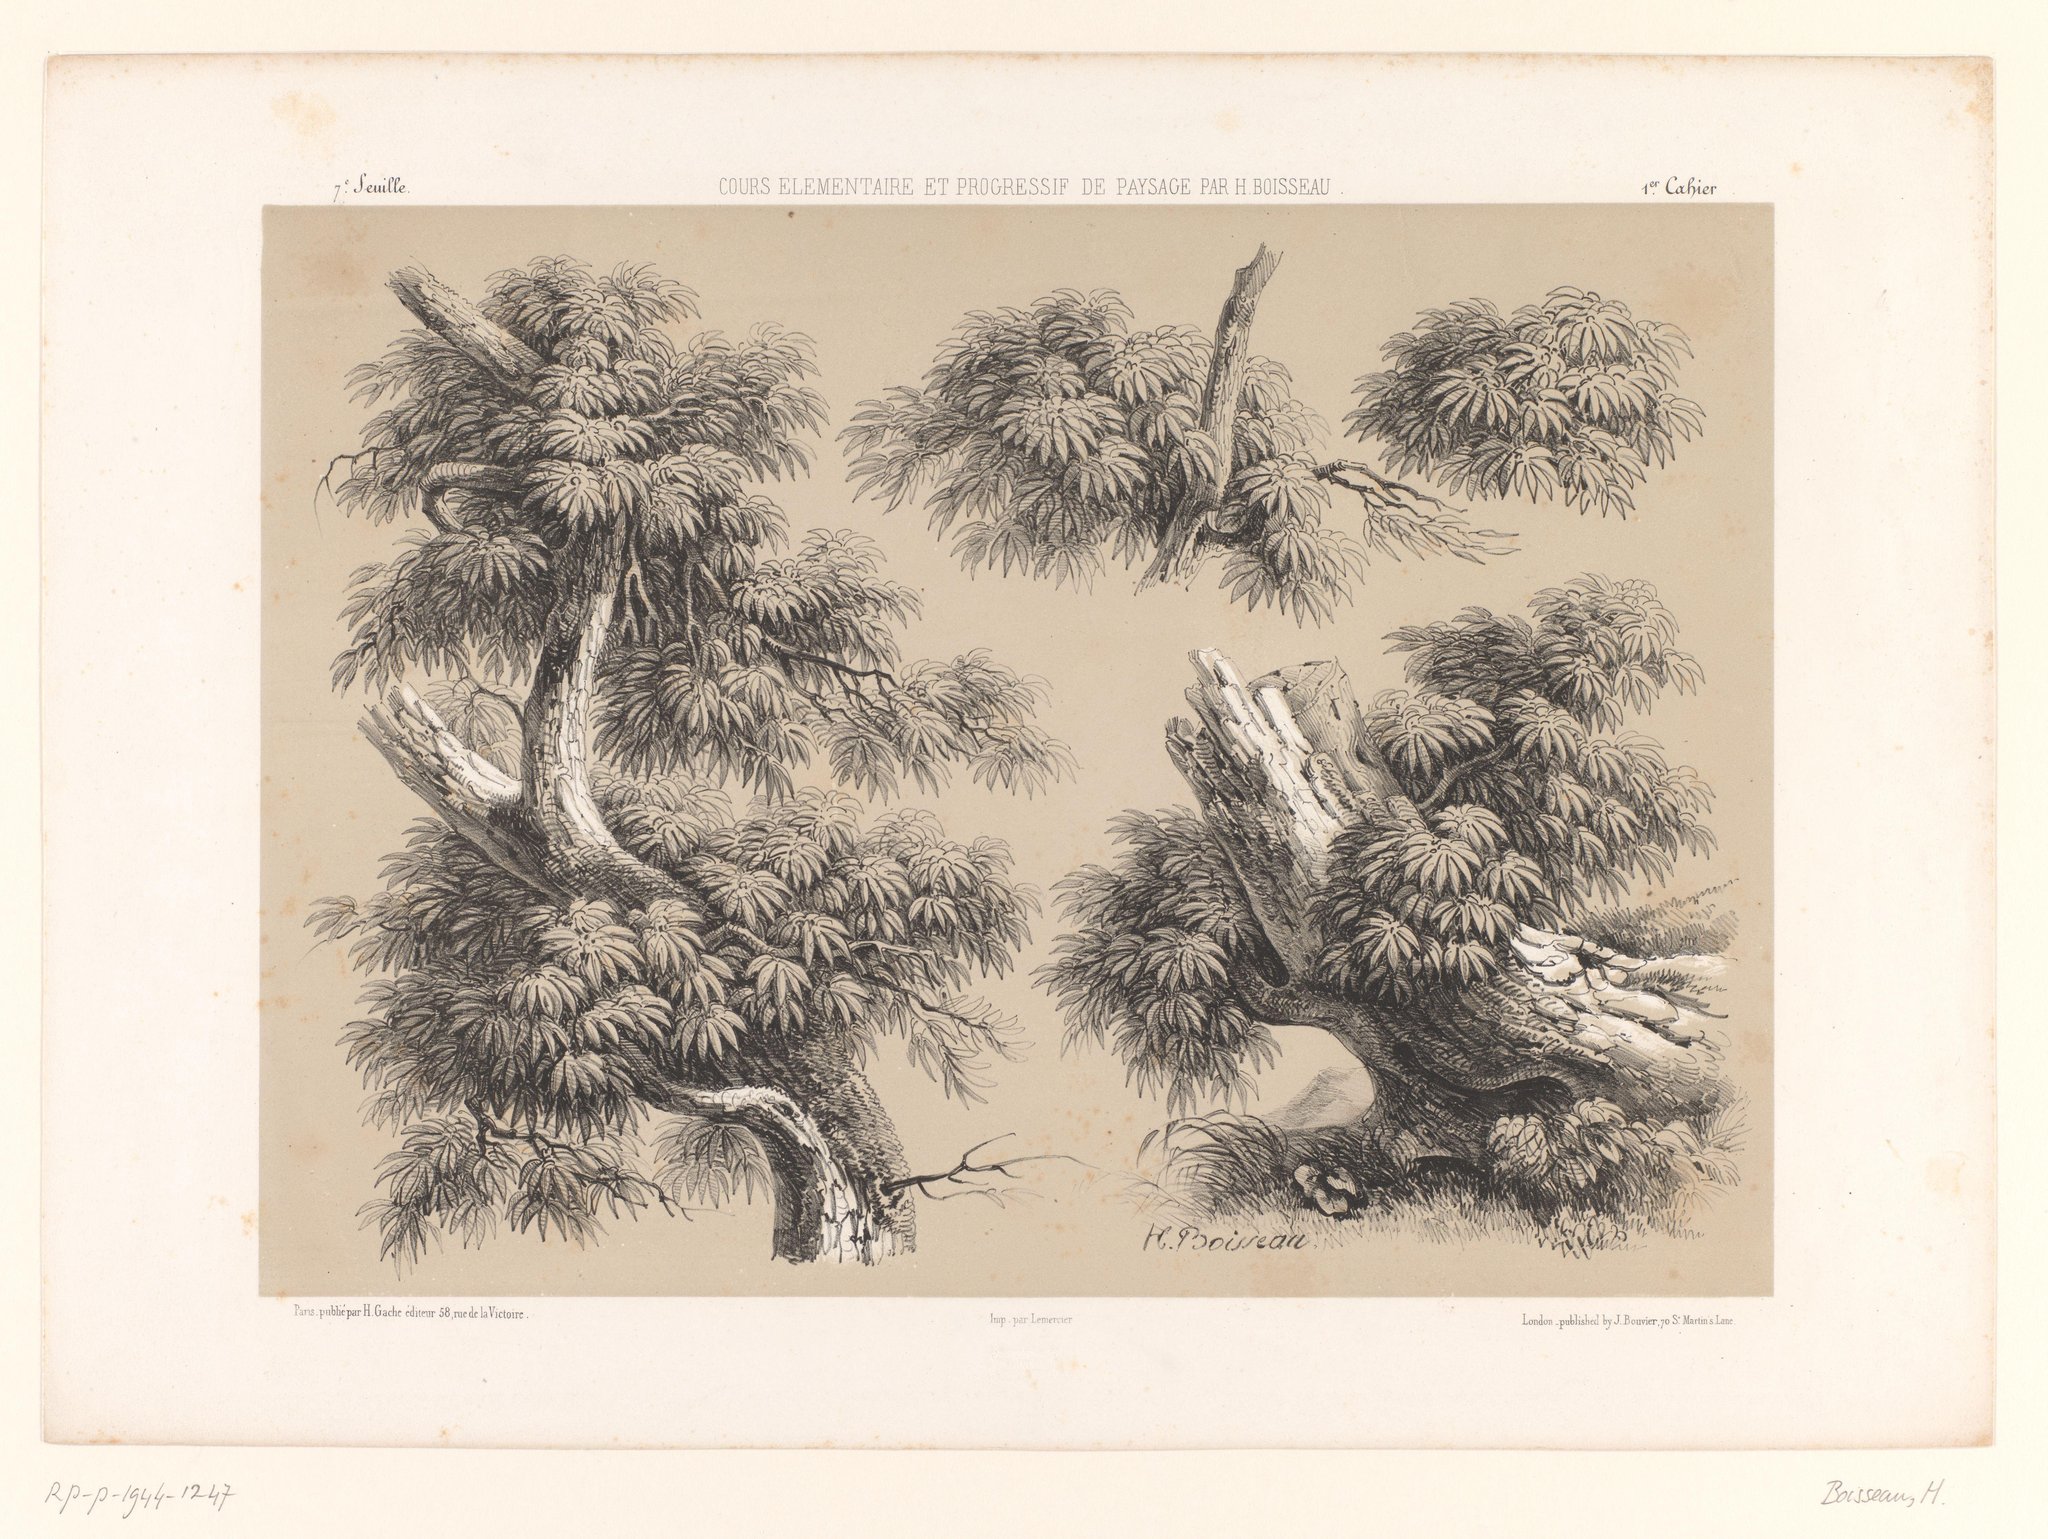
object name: print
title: Vier studies van boomstammen, takken en gebladerte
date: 1843-1846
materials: paper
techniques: tone lithography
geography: paris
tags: trees (+ leaf), trees (+ branch, stick), trees (+ stem, trunk)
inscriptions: collector's mark: Lugt 2228a, check stamp: Lugt 3977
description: Tweede serie, eerste cahier, zevende blad.